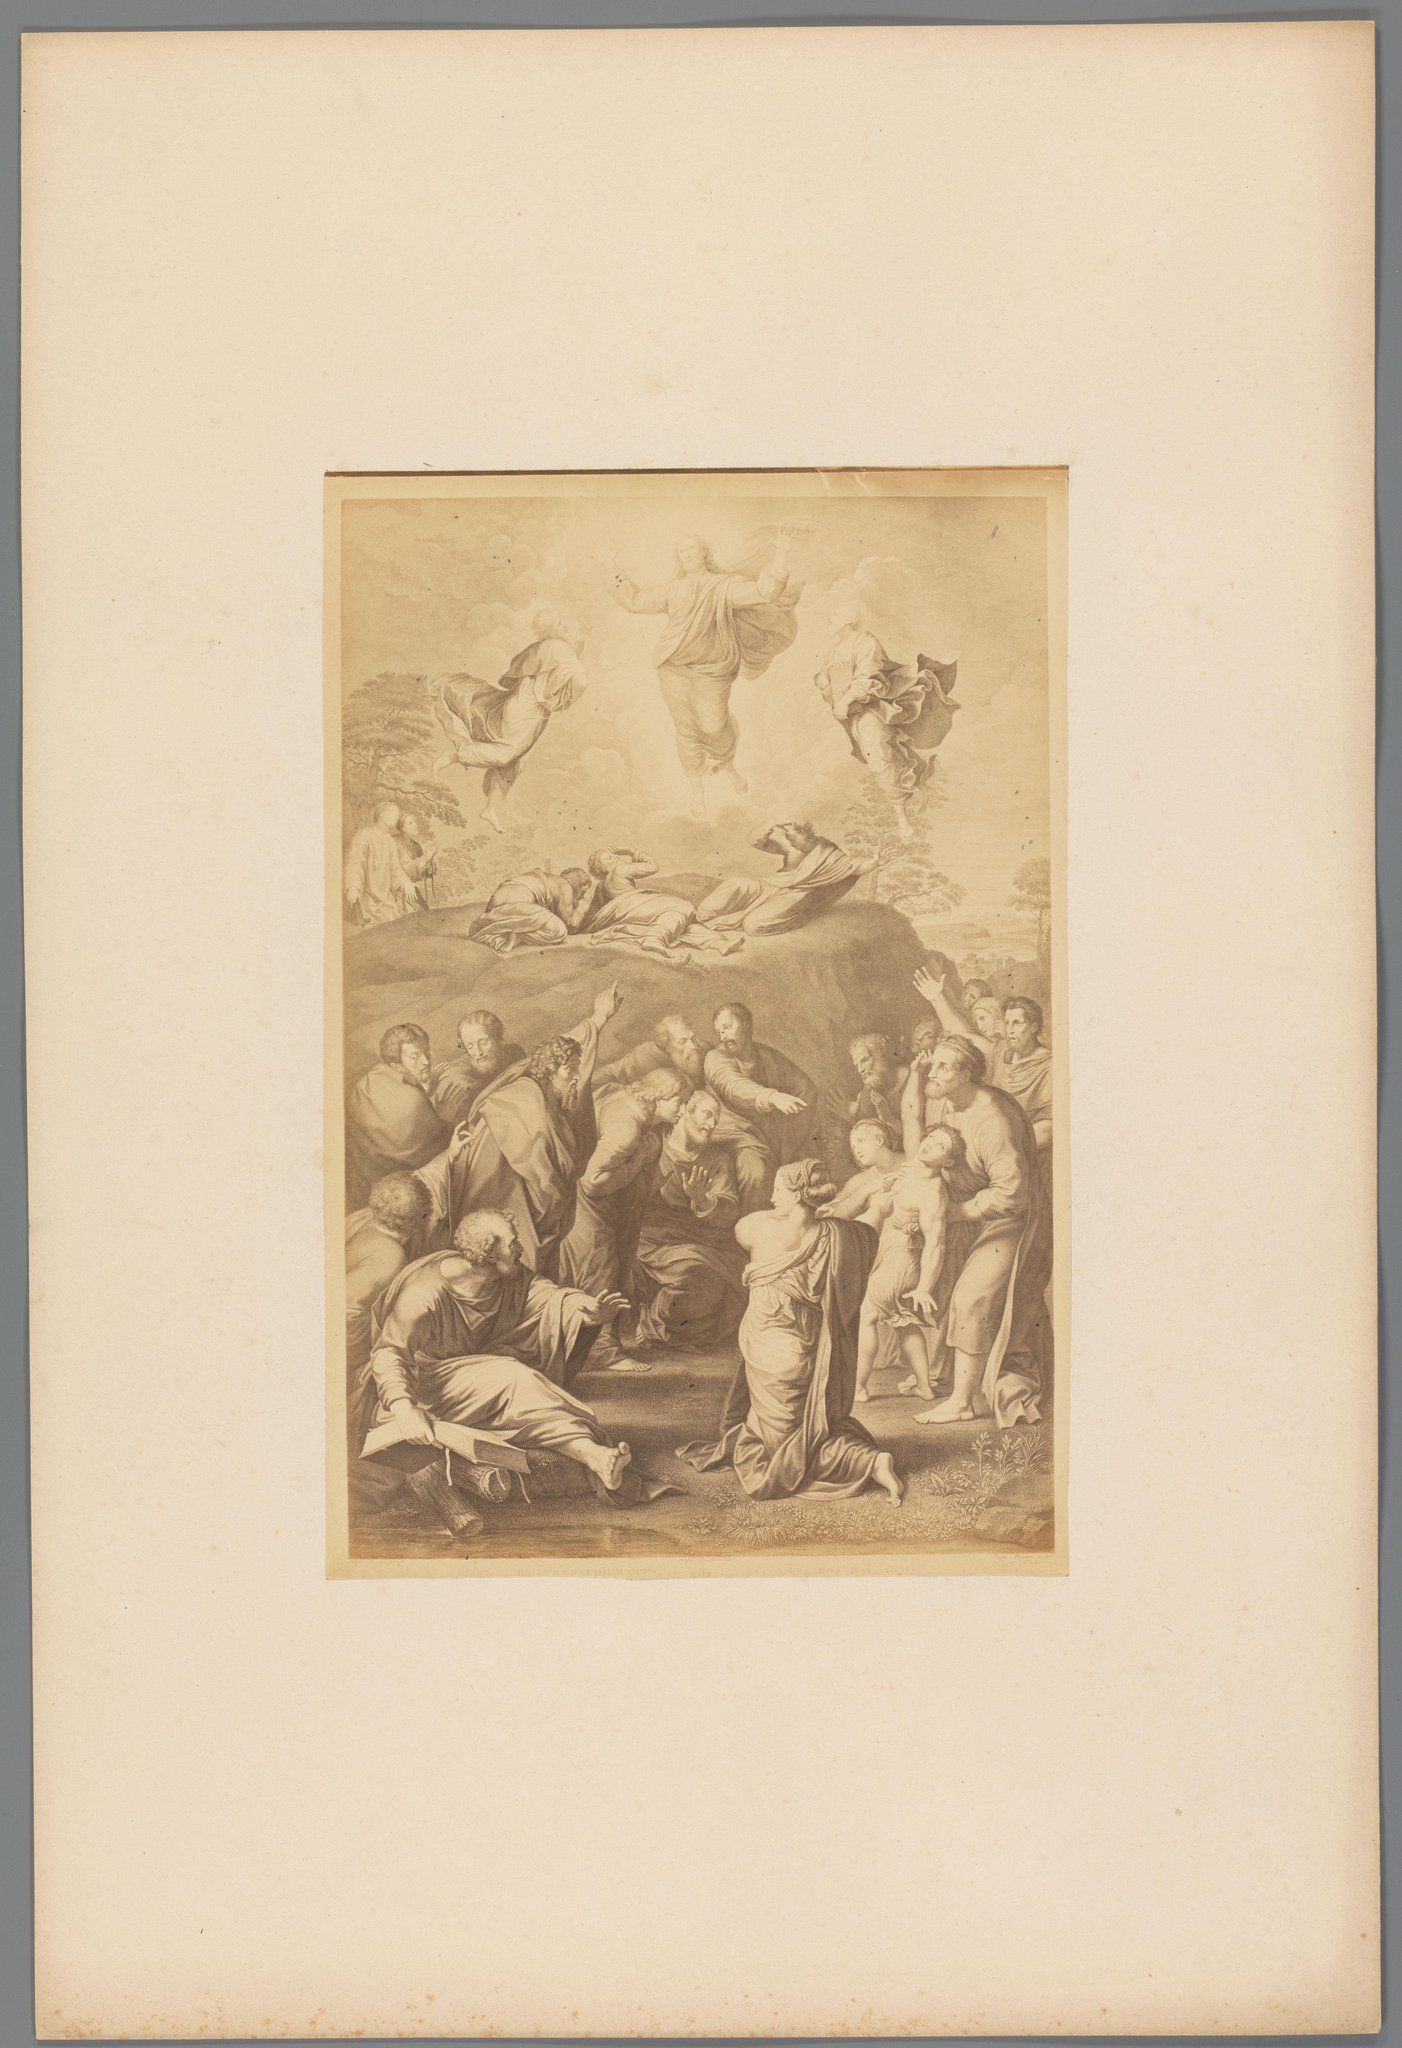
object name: photograph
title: Fotoreproductie van een prent van het schilderij De transfiguratie naar Rafaël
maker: Anonymous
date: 1851-1900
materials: cardboard, paper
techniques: albumen print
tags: print, e.g.: engraving, etching, lithograph, the transfiguration: moses and elijah appear on either side of christ on mount tabor (matthew 17:1-13; mark 9:2-13; luke 9:28-36)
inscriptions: inscription: ‘[...]’